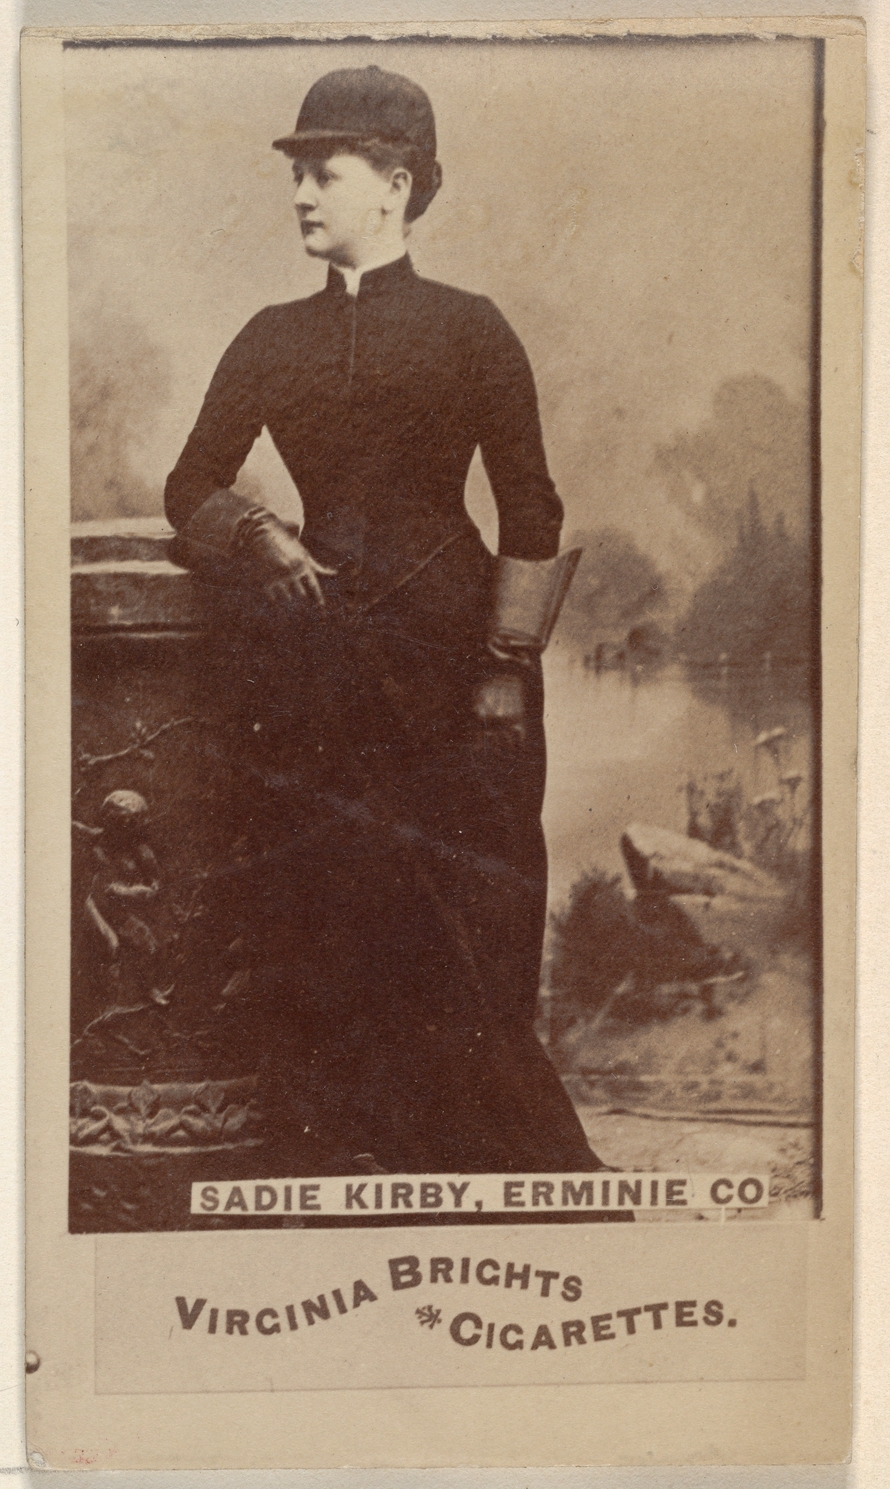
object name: photograph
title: Sadie Kirby, Erminie Co., from the Actors and Actresses series (N45, Type 6) for Virginia Brights Cigarettes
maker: allen & ginter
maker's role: publisher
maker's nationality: american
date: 1888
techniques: albumen silver print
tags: portraits,women,actresses